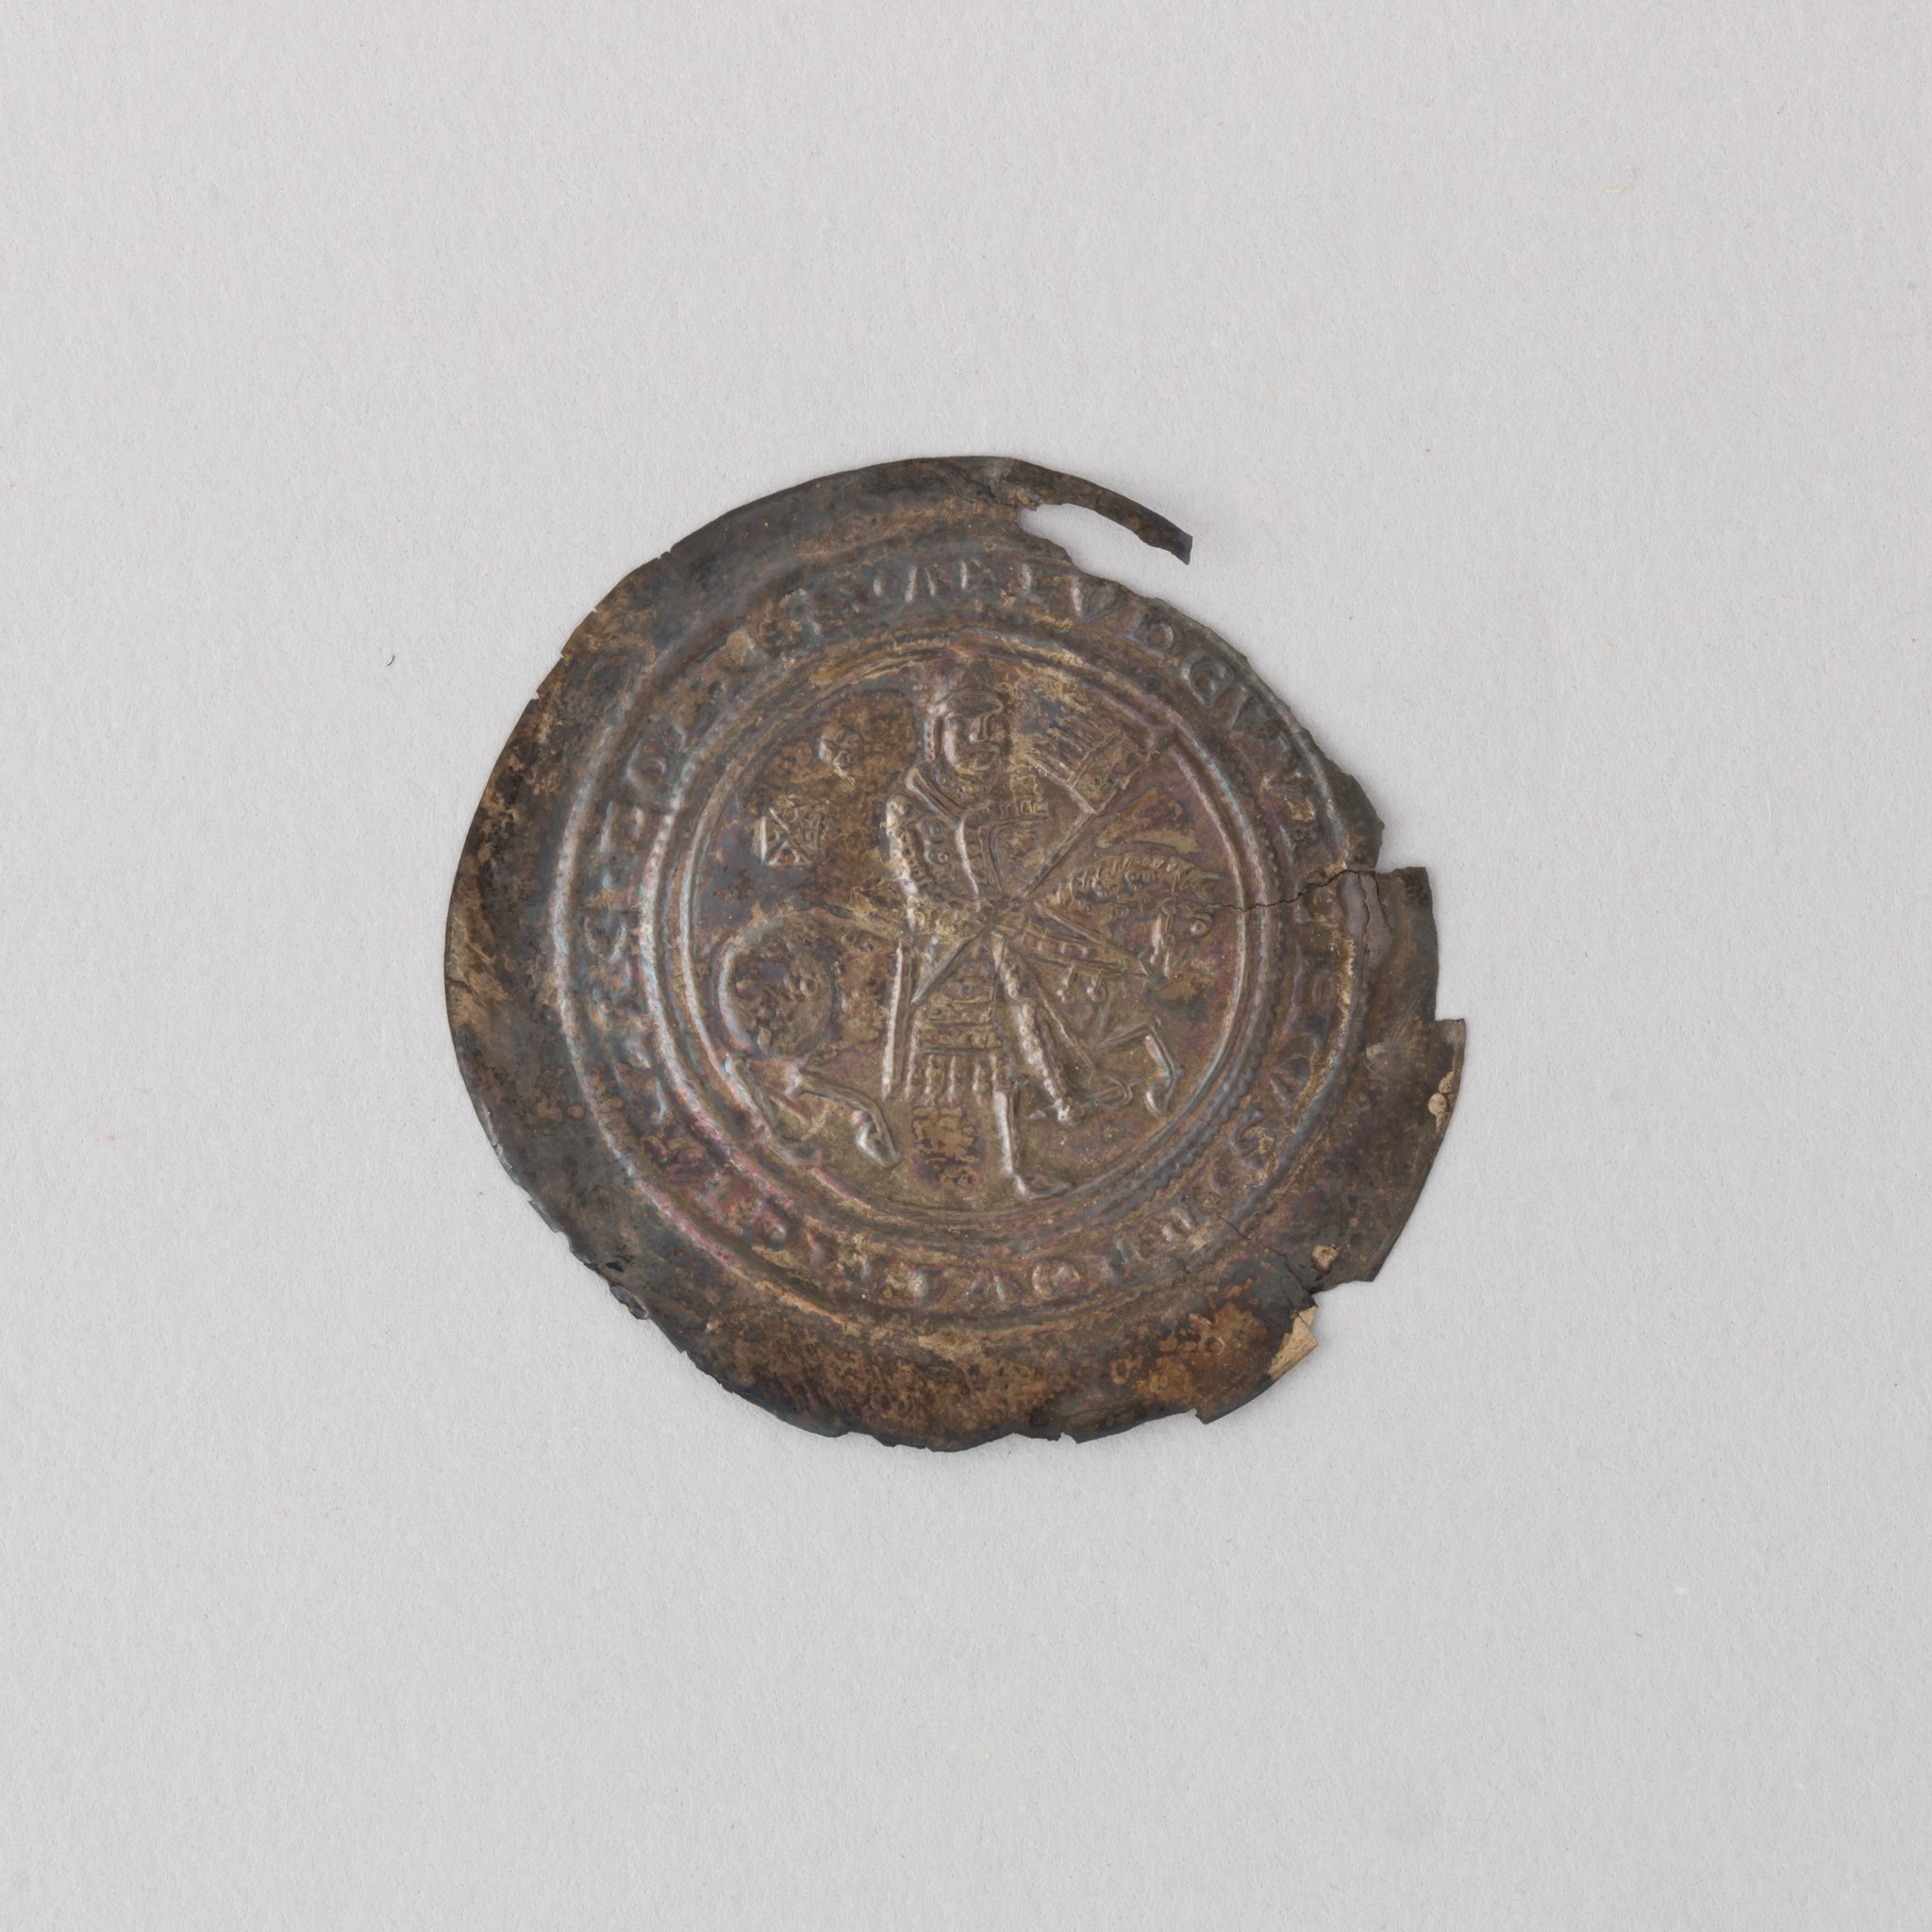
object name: coin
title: Coin Showing Ludwig III (Louis III (the Pious))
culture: german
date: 1101-1200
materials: gold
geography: germany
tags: coins